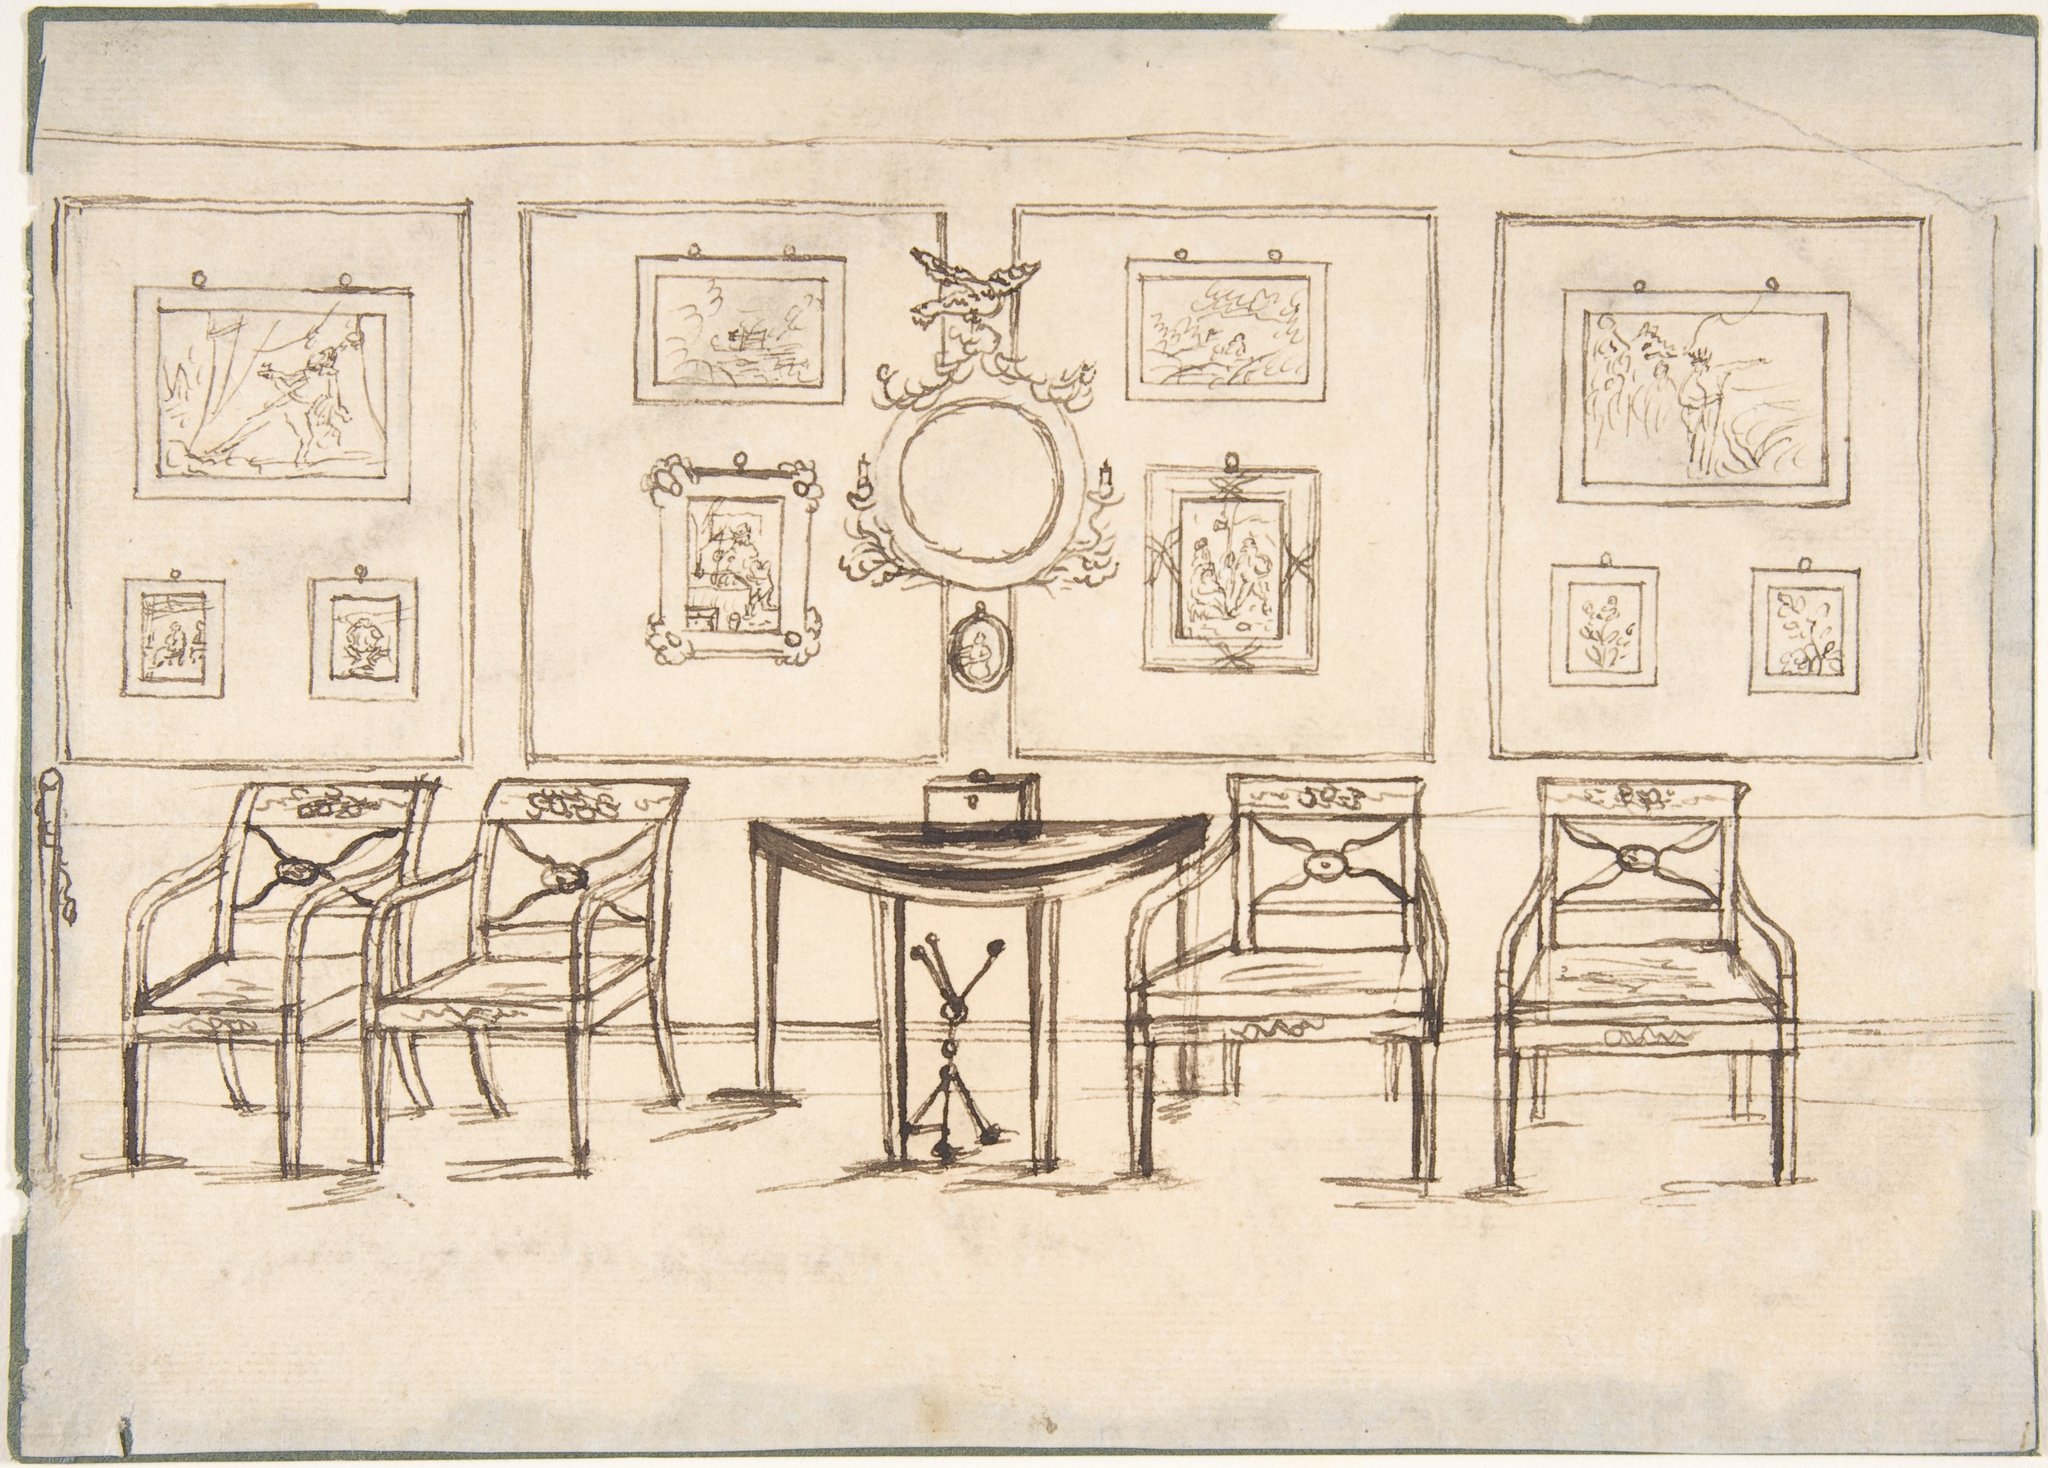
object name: drawing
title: Interior with Four Armchairs, a Round Mirror, Demilune Table and Framed Prints or Drawings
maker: anonymous, british, late 18th century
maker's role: artist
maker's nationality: british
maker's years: 1750-1800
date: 1767-1800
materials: ink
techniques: pen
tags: interiors,chairs,tables,mirrors